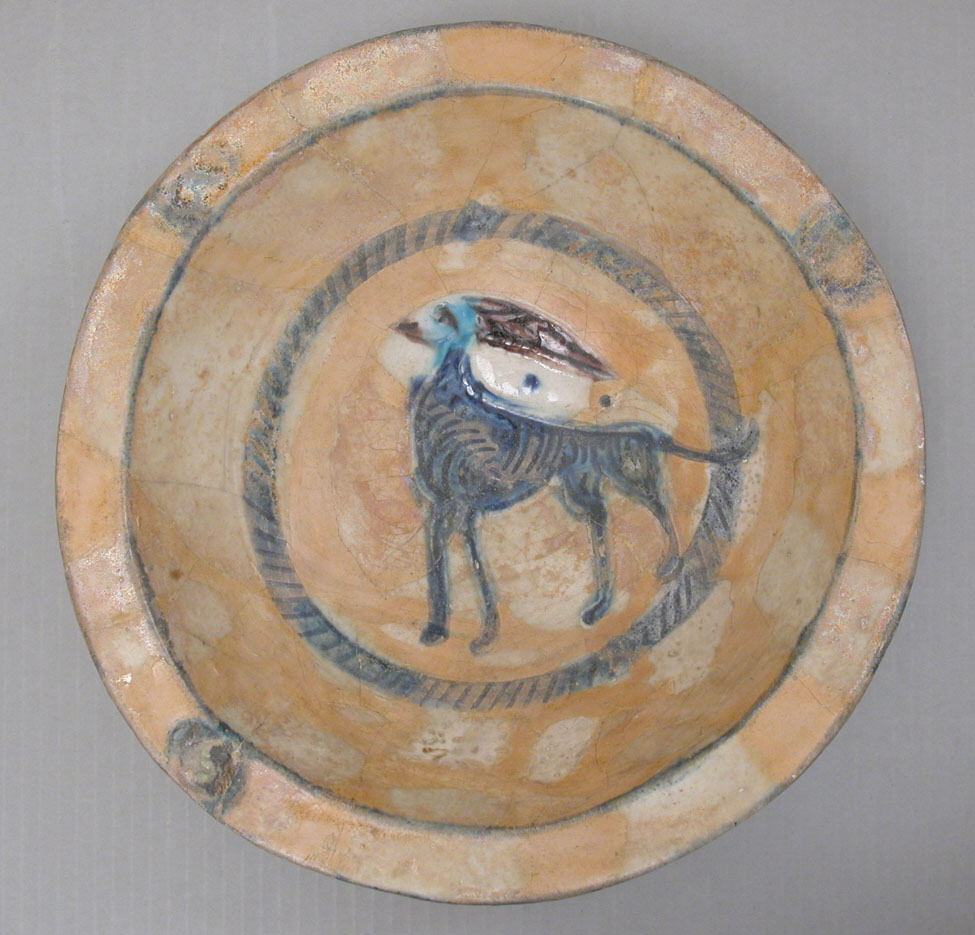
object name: bowl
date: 1101-1200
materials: earthenware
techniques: glazing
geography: syria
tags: animals